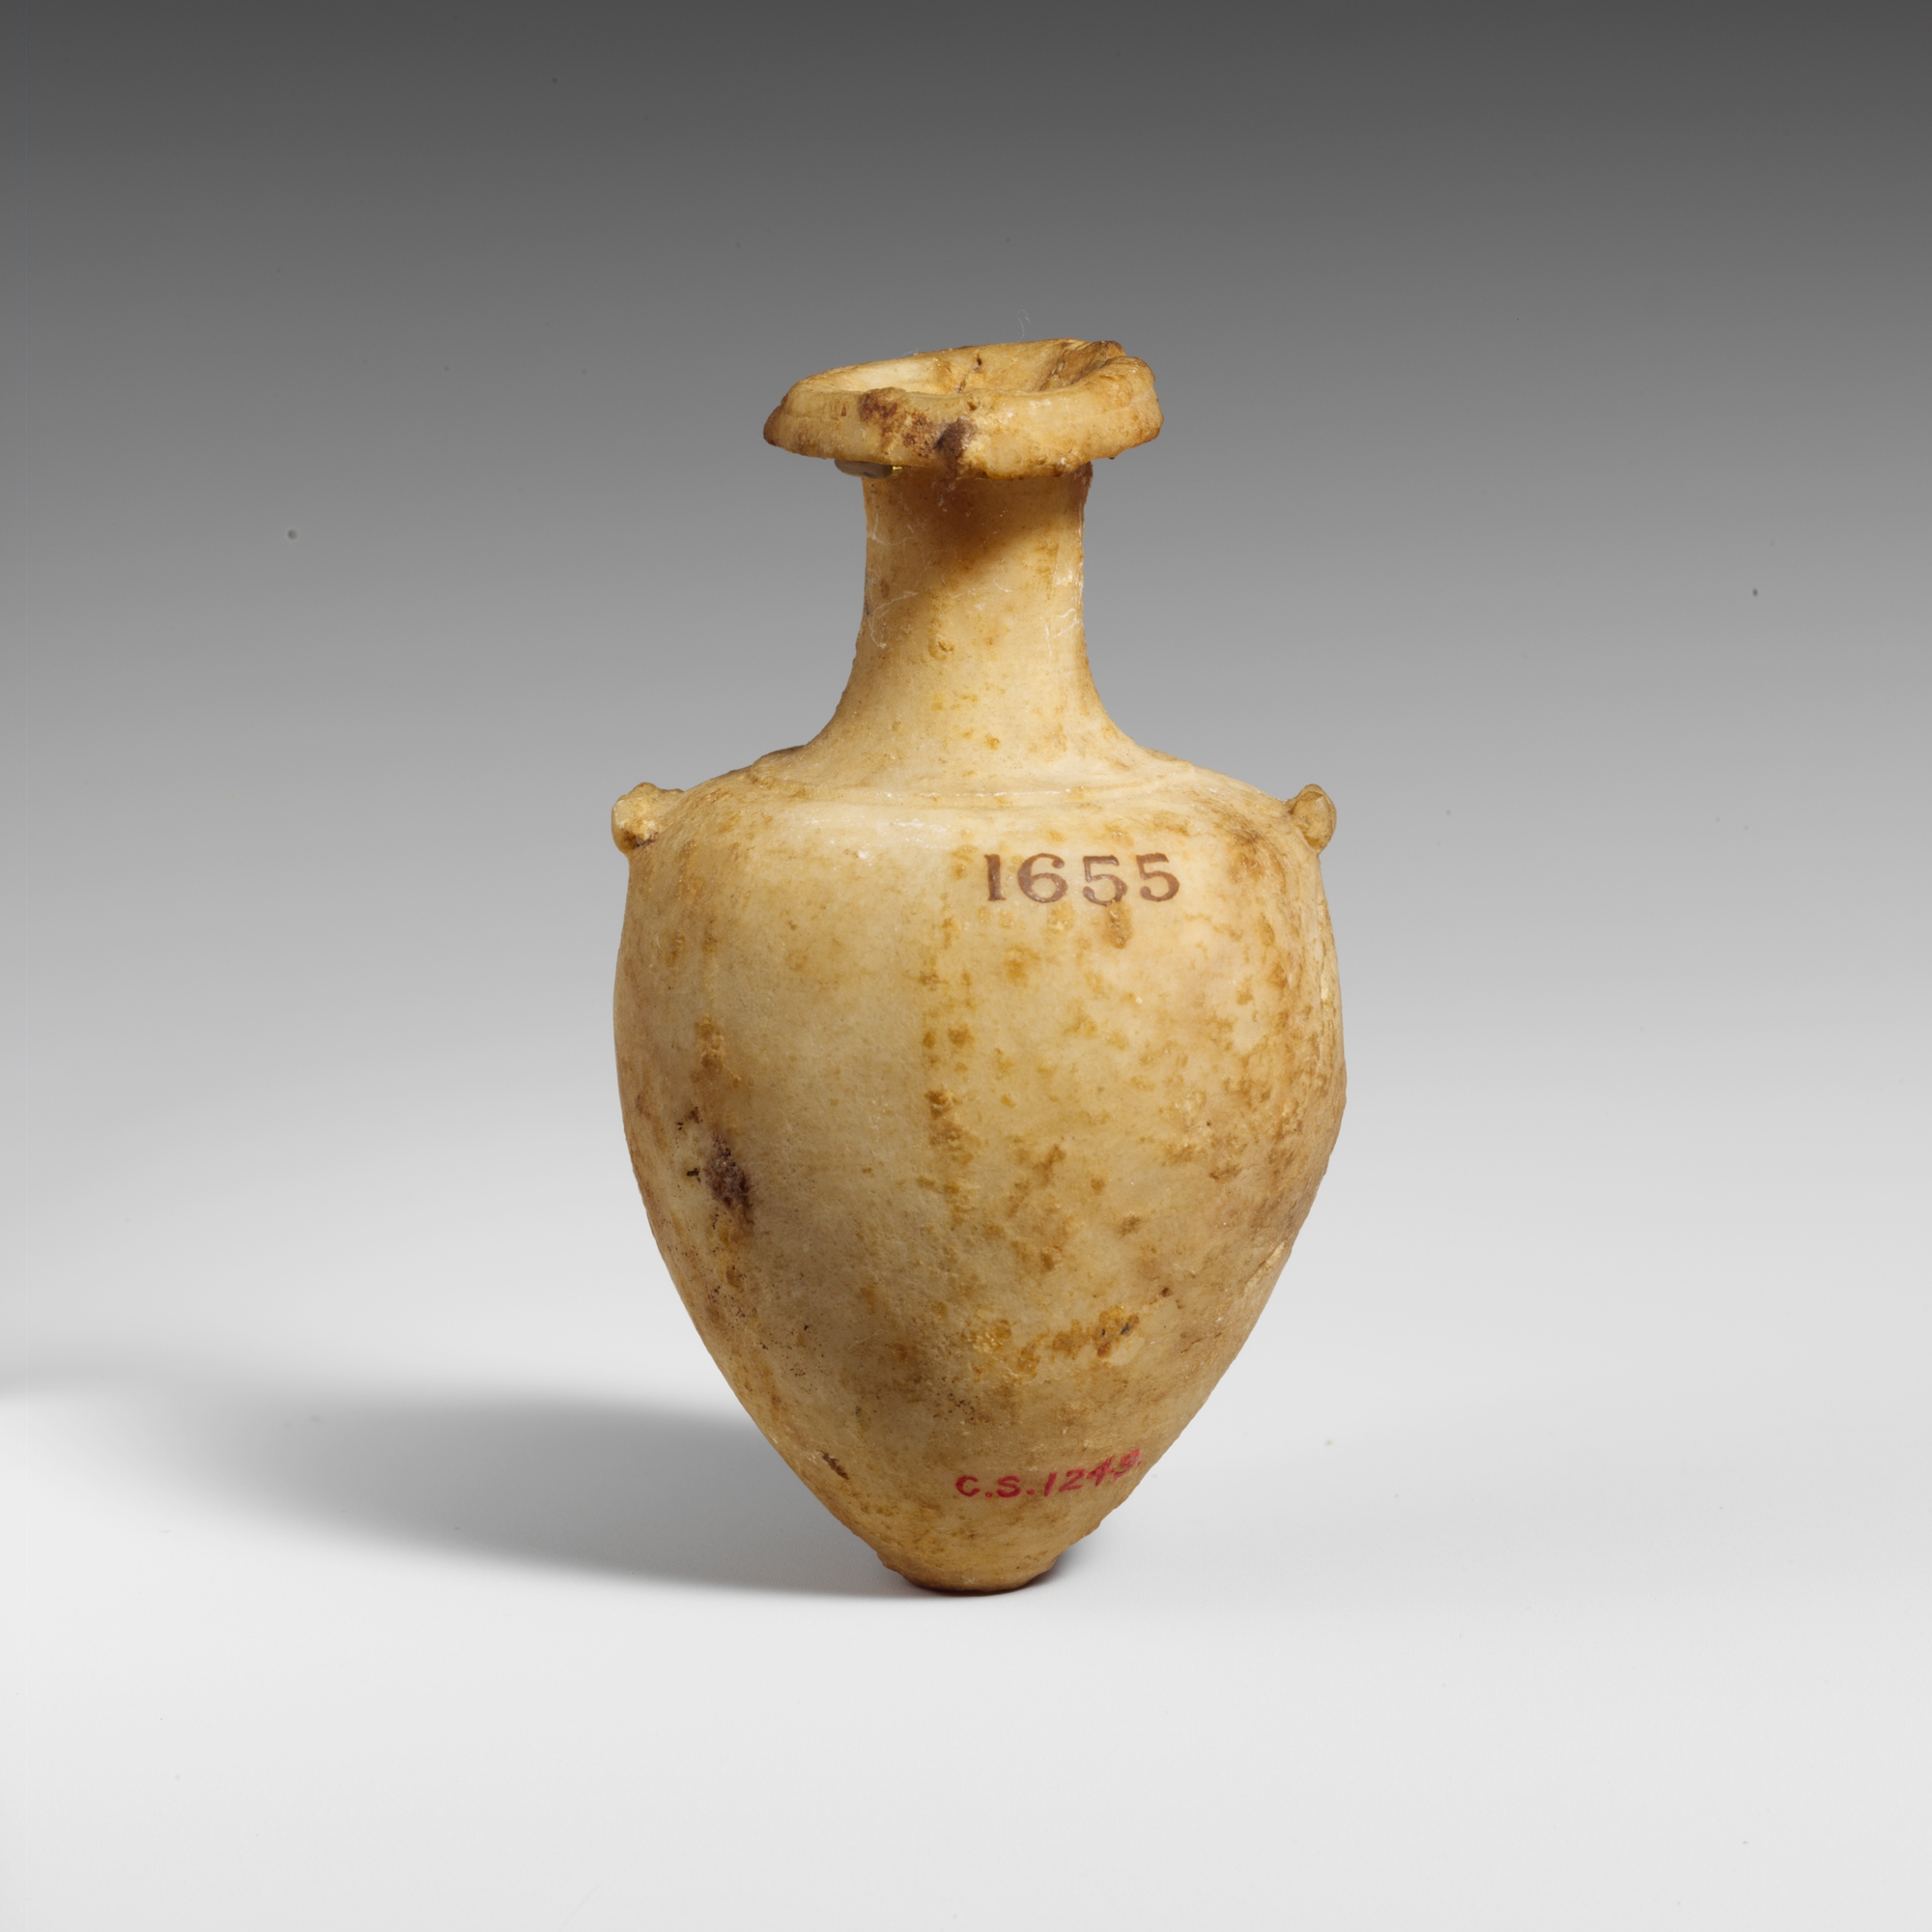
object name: amphora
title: Miniature alabaster amphora (jar)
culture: cypriot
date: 334-201 BCE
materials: gypsum